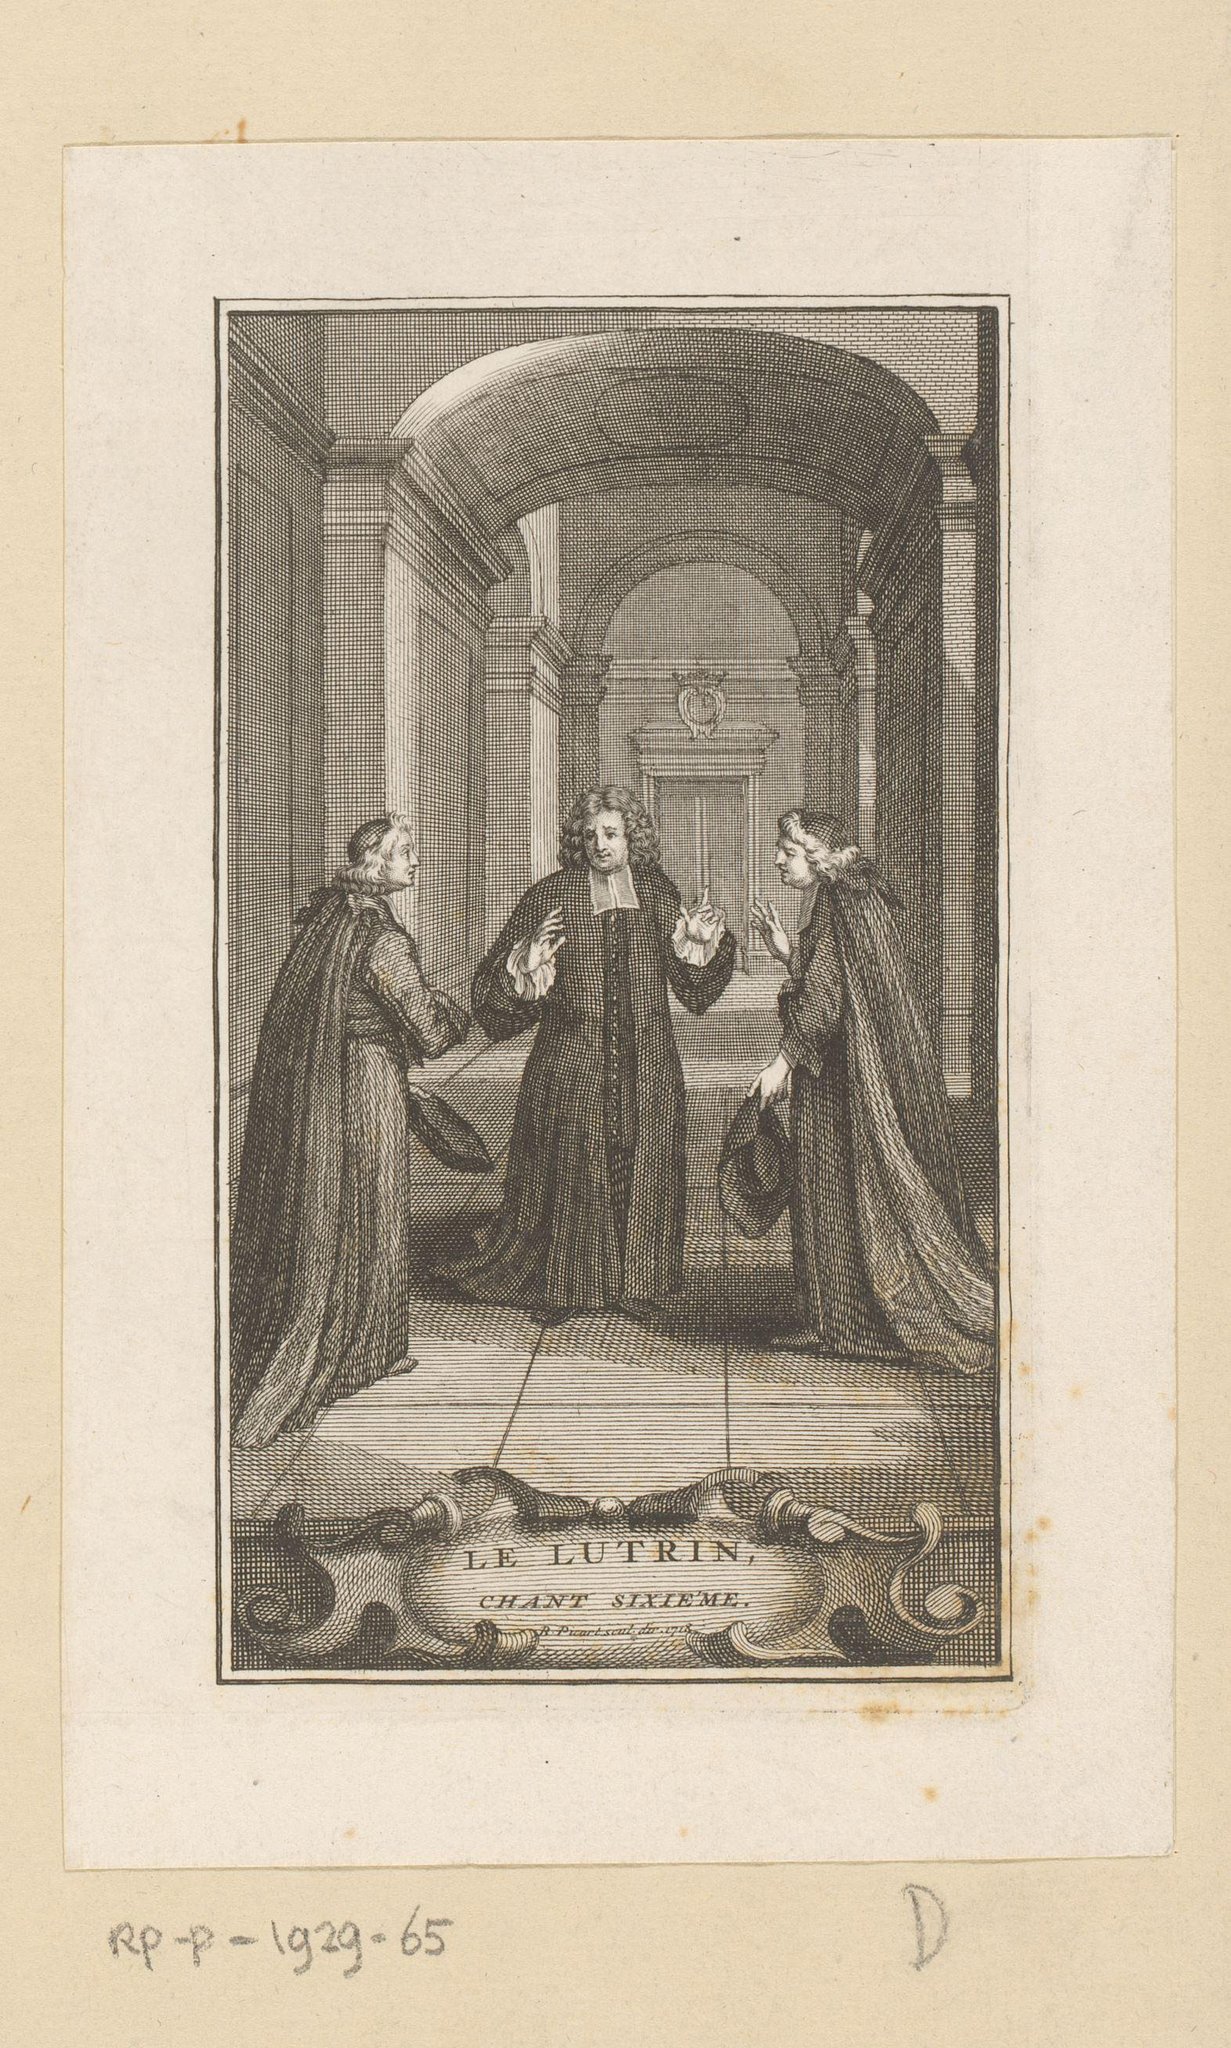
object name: print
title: Le Lutrin, Chant Sixieme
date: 1718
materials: paper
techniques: engraving, etching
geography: amsterdam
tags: corridor, debate, discussion (~ meeting), organization, functionaries and dignitaries in roman catholic church; clergy in general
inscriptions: collector's mark: Lugt 240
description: Deze prent is de kleine variant van een prent met hetzelfde onderwerp gebruikt in eerdere publicaties. Prent ook gebruikt in: Boileau, Nicolas. Oeuvres de Nicolas Boileau Despréaux. Den Haag: Isaac Vaillant, Pierre Gosse en Pieter de Hondt, 1722, dl. 2.